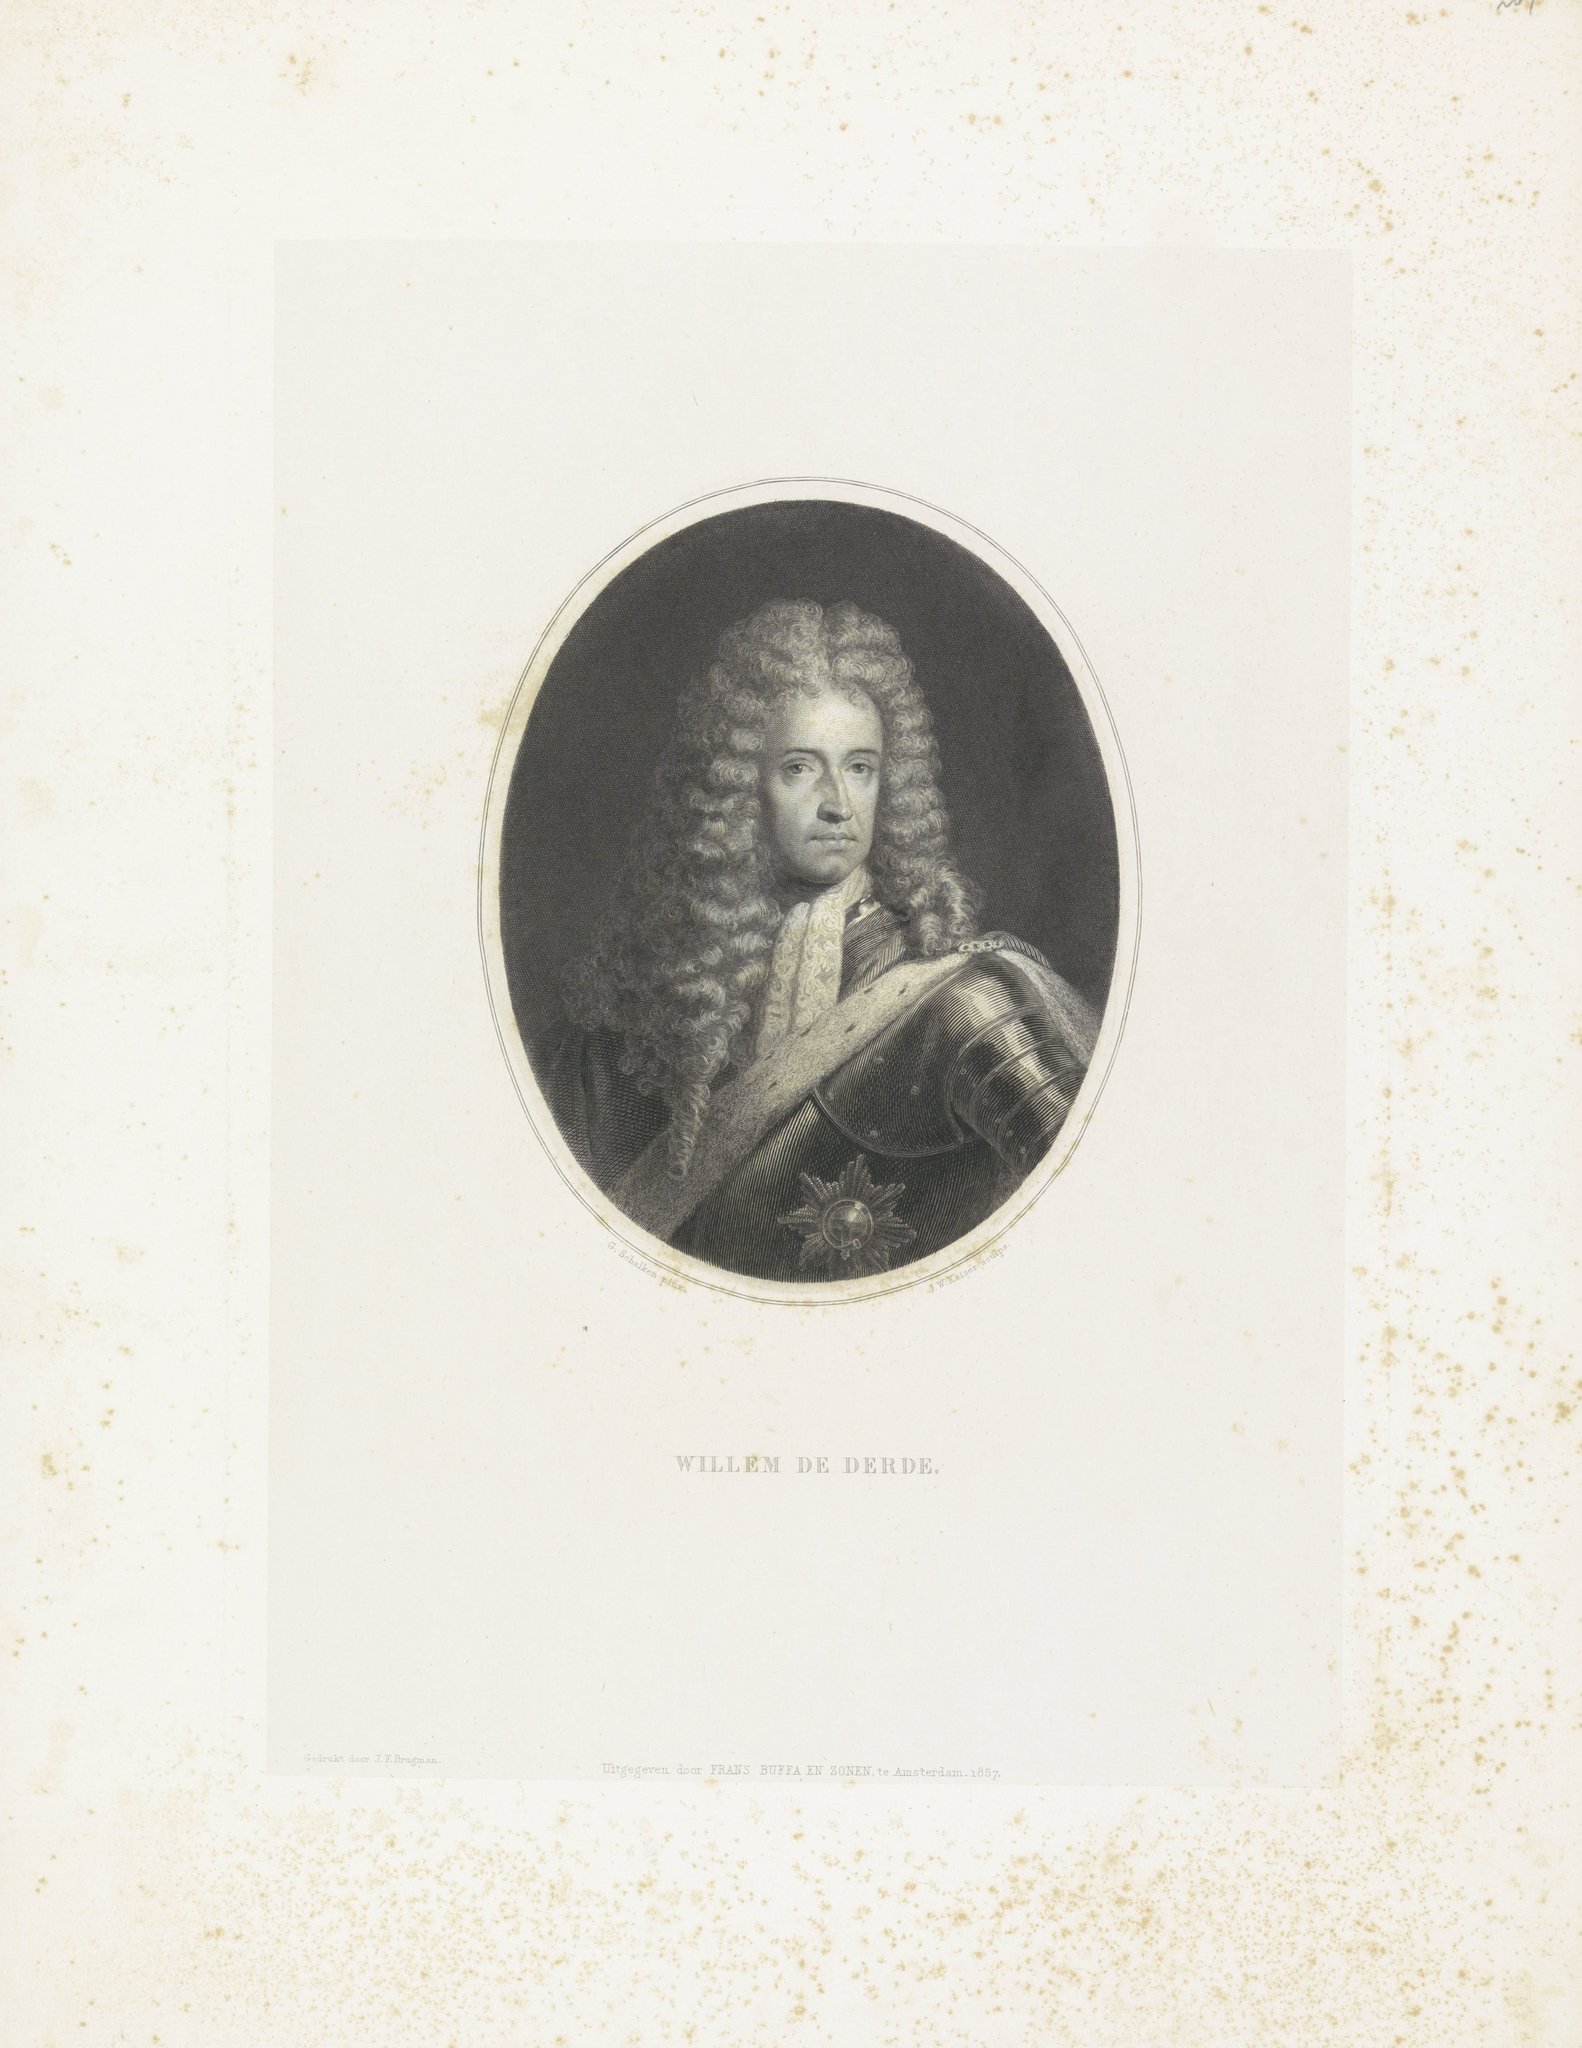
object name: print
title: Portret van Willem III, prins van Oranje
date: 1857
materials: paper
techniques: engraving, etching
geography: amsterdam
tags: william iii (prince of orange and king of england, scotland, and ireland), knighthood order (garter) - insignia of a knighthood order, e.g.: badge, chain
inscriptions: date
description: De hier vermelde titel verwijst naar de hoogst verkregen titel van de geportretteerde, niet per se naar de titel die de geportretteerde op deze voorstelling draagt.